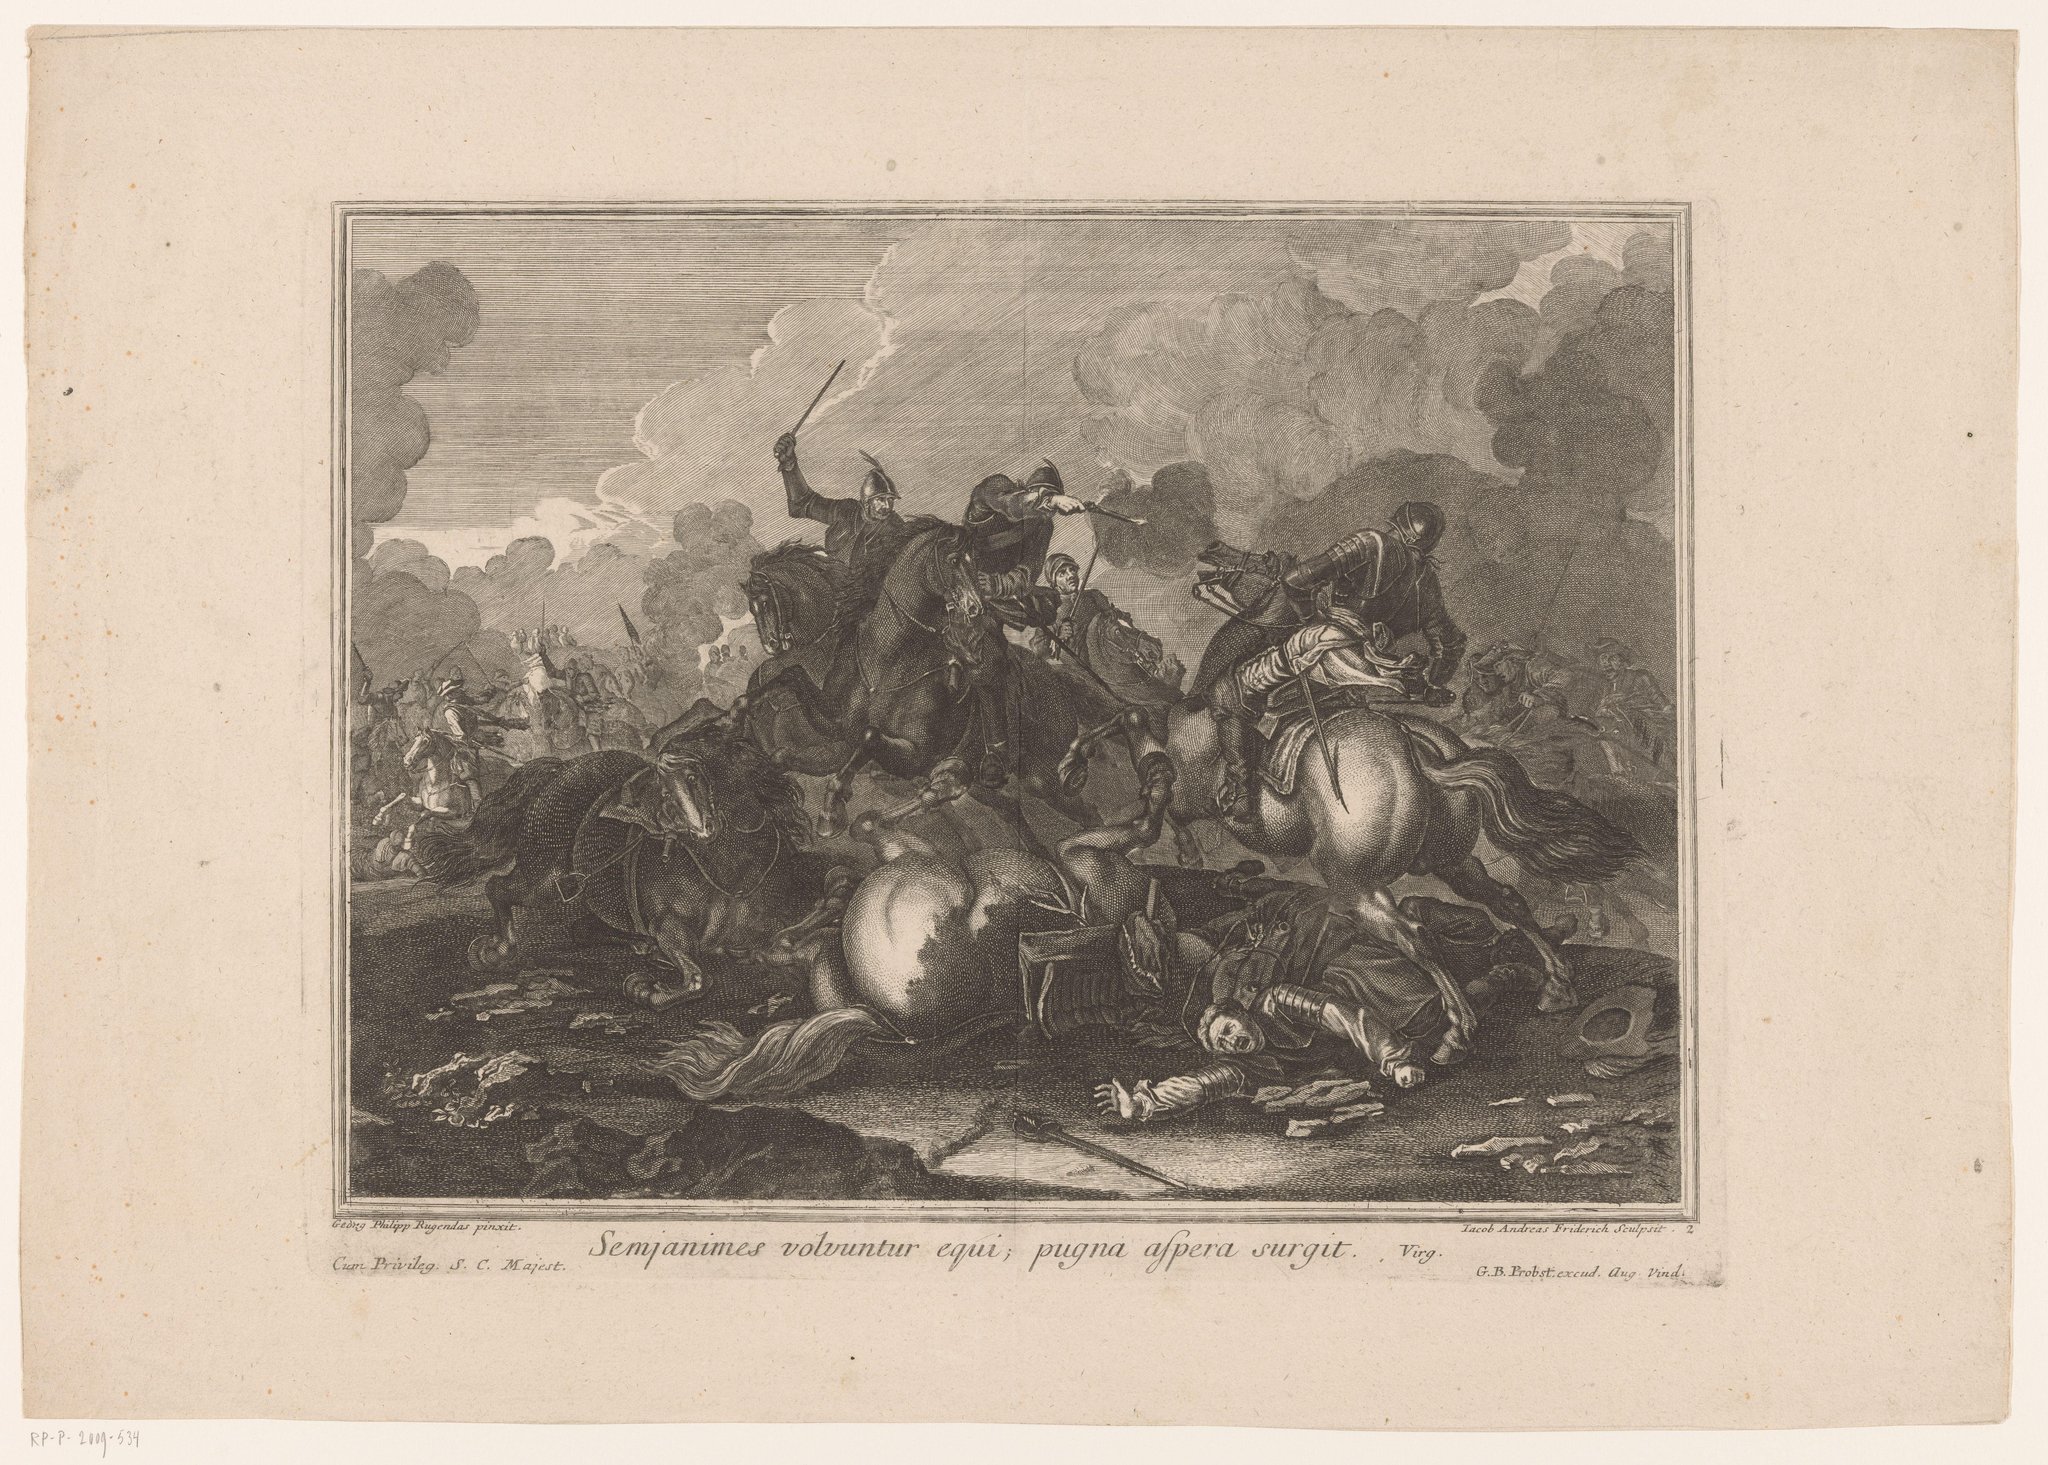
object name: print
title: Semjanimes volvuntur equi; pugna aspera surgit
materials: paper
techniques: engraving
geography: augsburg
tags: charge ~ battle (+ cavalry, horsemen), putting the enemy out of action, hacking and thrusting weapons: sword, firearms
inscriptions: collector's mark: Lugt 2228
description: Uit een serie van vier ruitergevechten. Origineel uitgegeven door Jeremias Wolff.